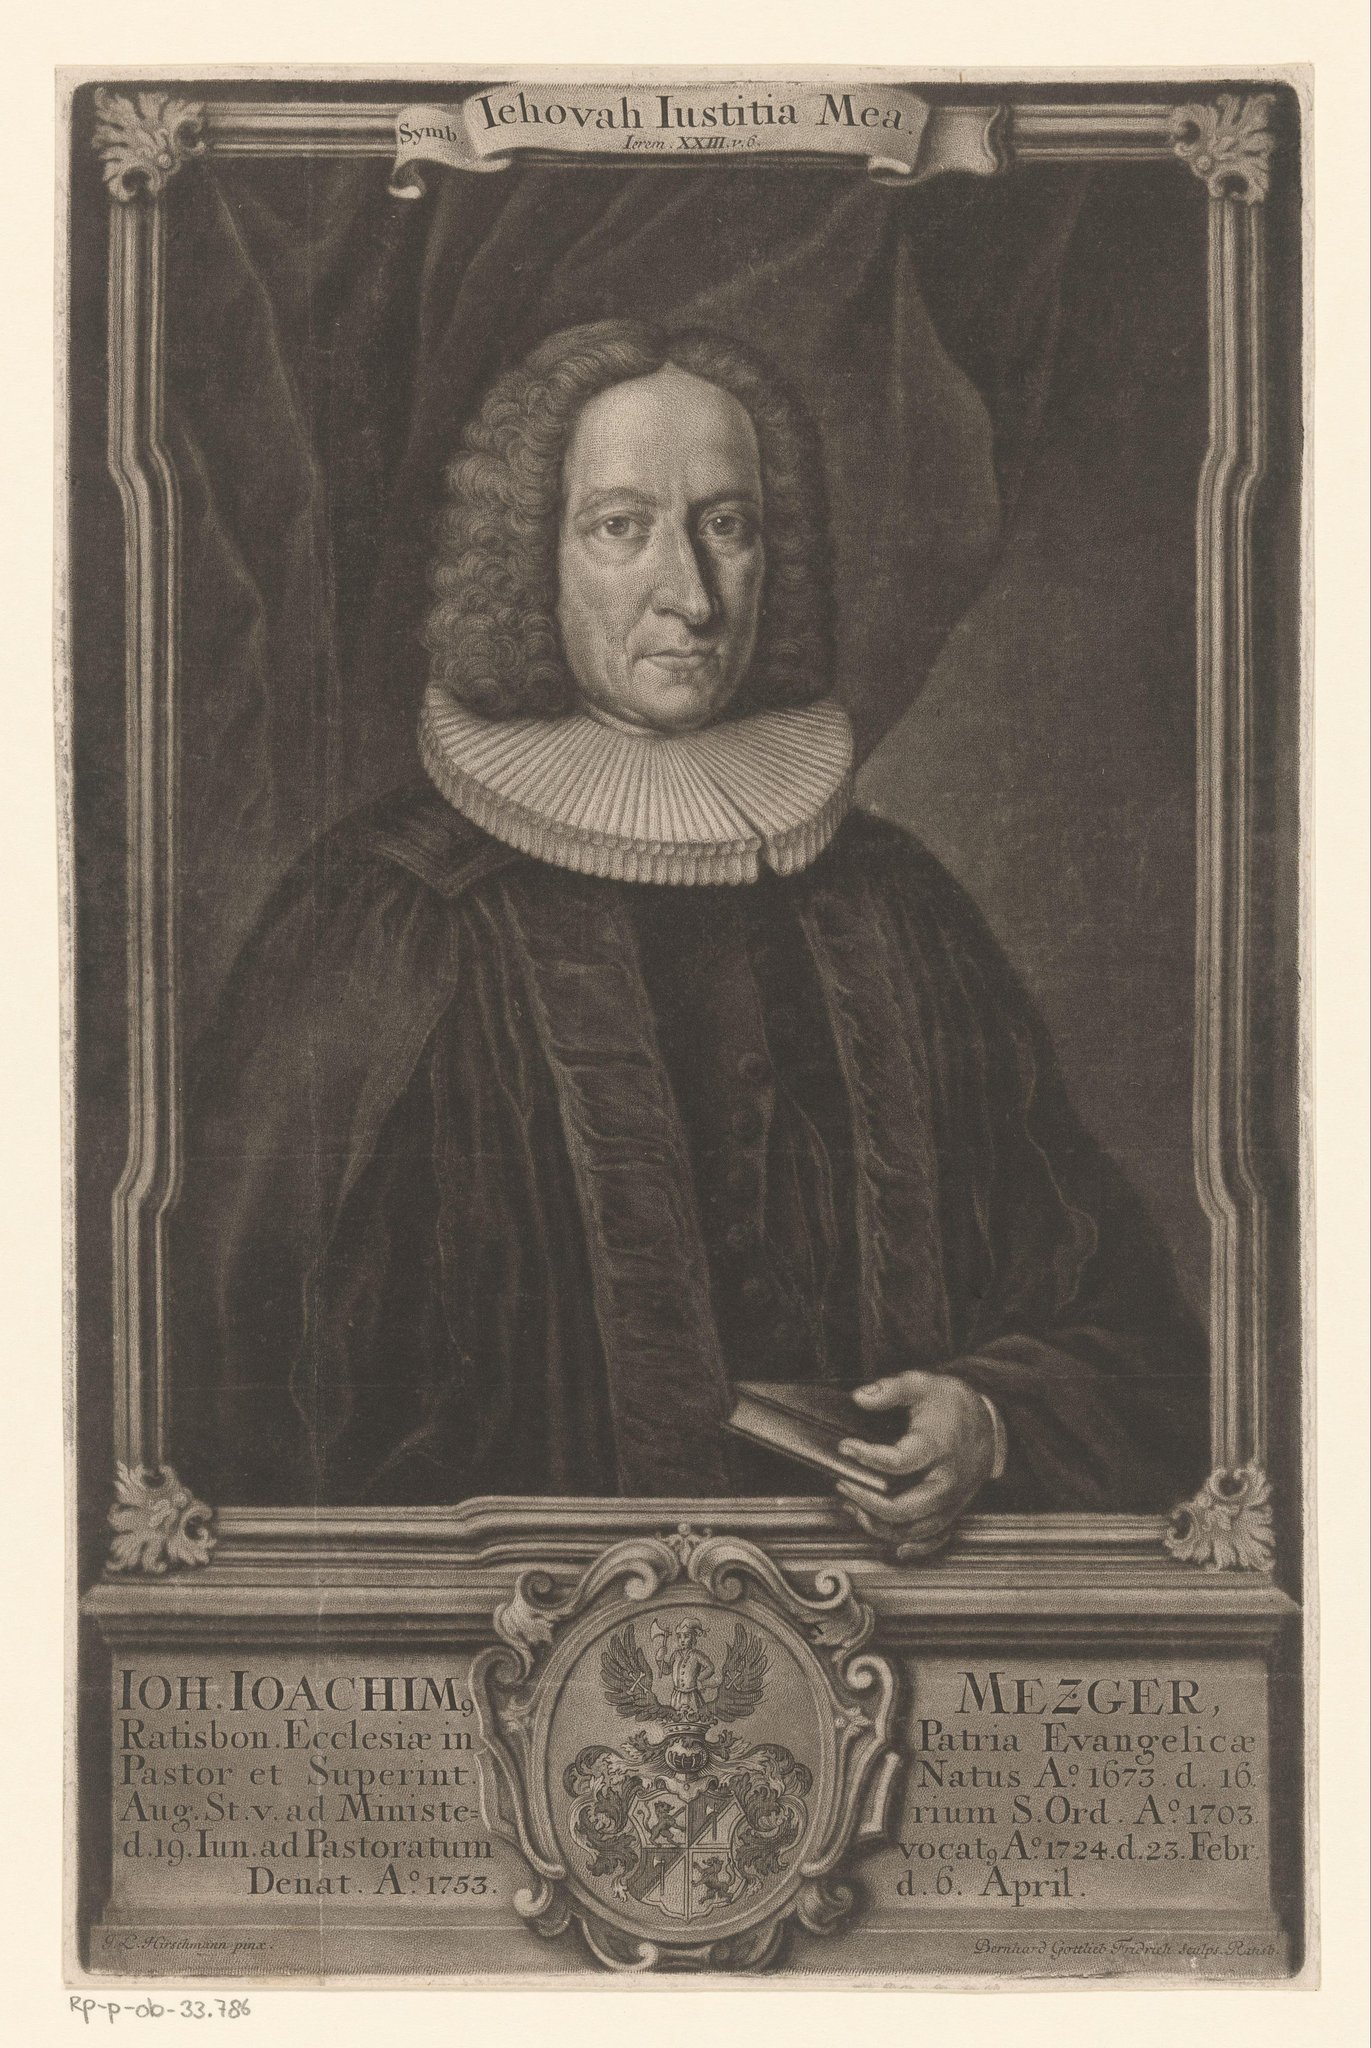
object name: print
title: Portret van Johann Joachim Metzger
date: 1753-1756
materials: paper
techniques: mezzotint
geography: regensburg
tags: historical persons, book, armorial bearing, heraldry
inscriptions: collector's mark: Lugt 2228